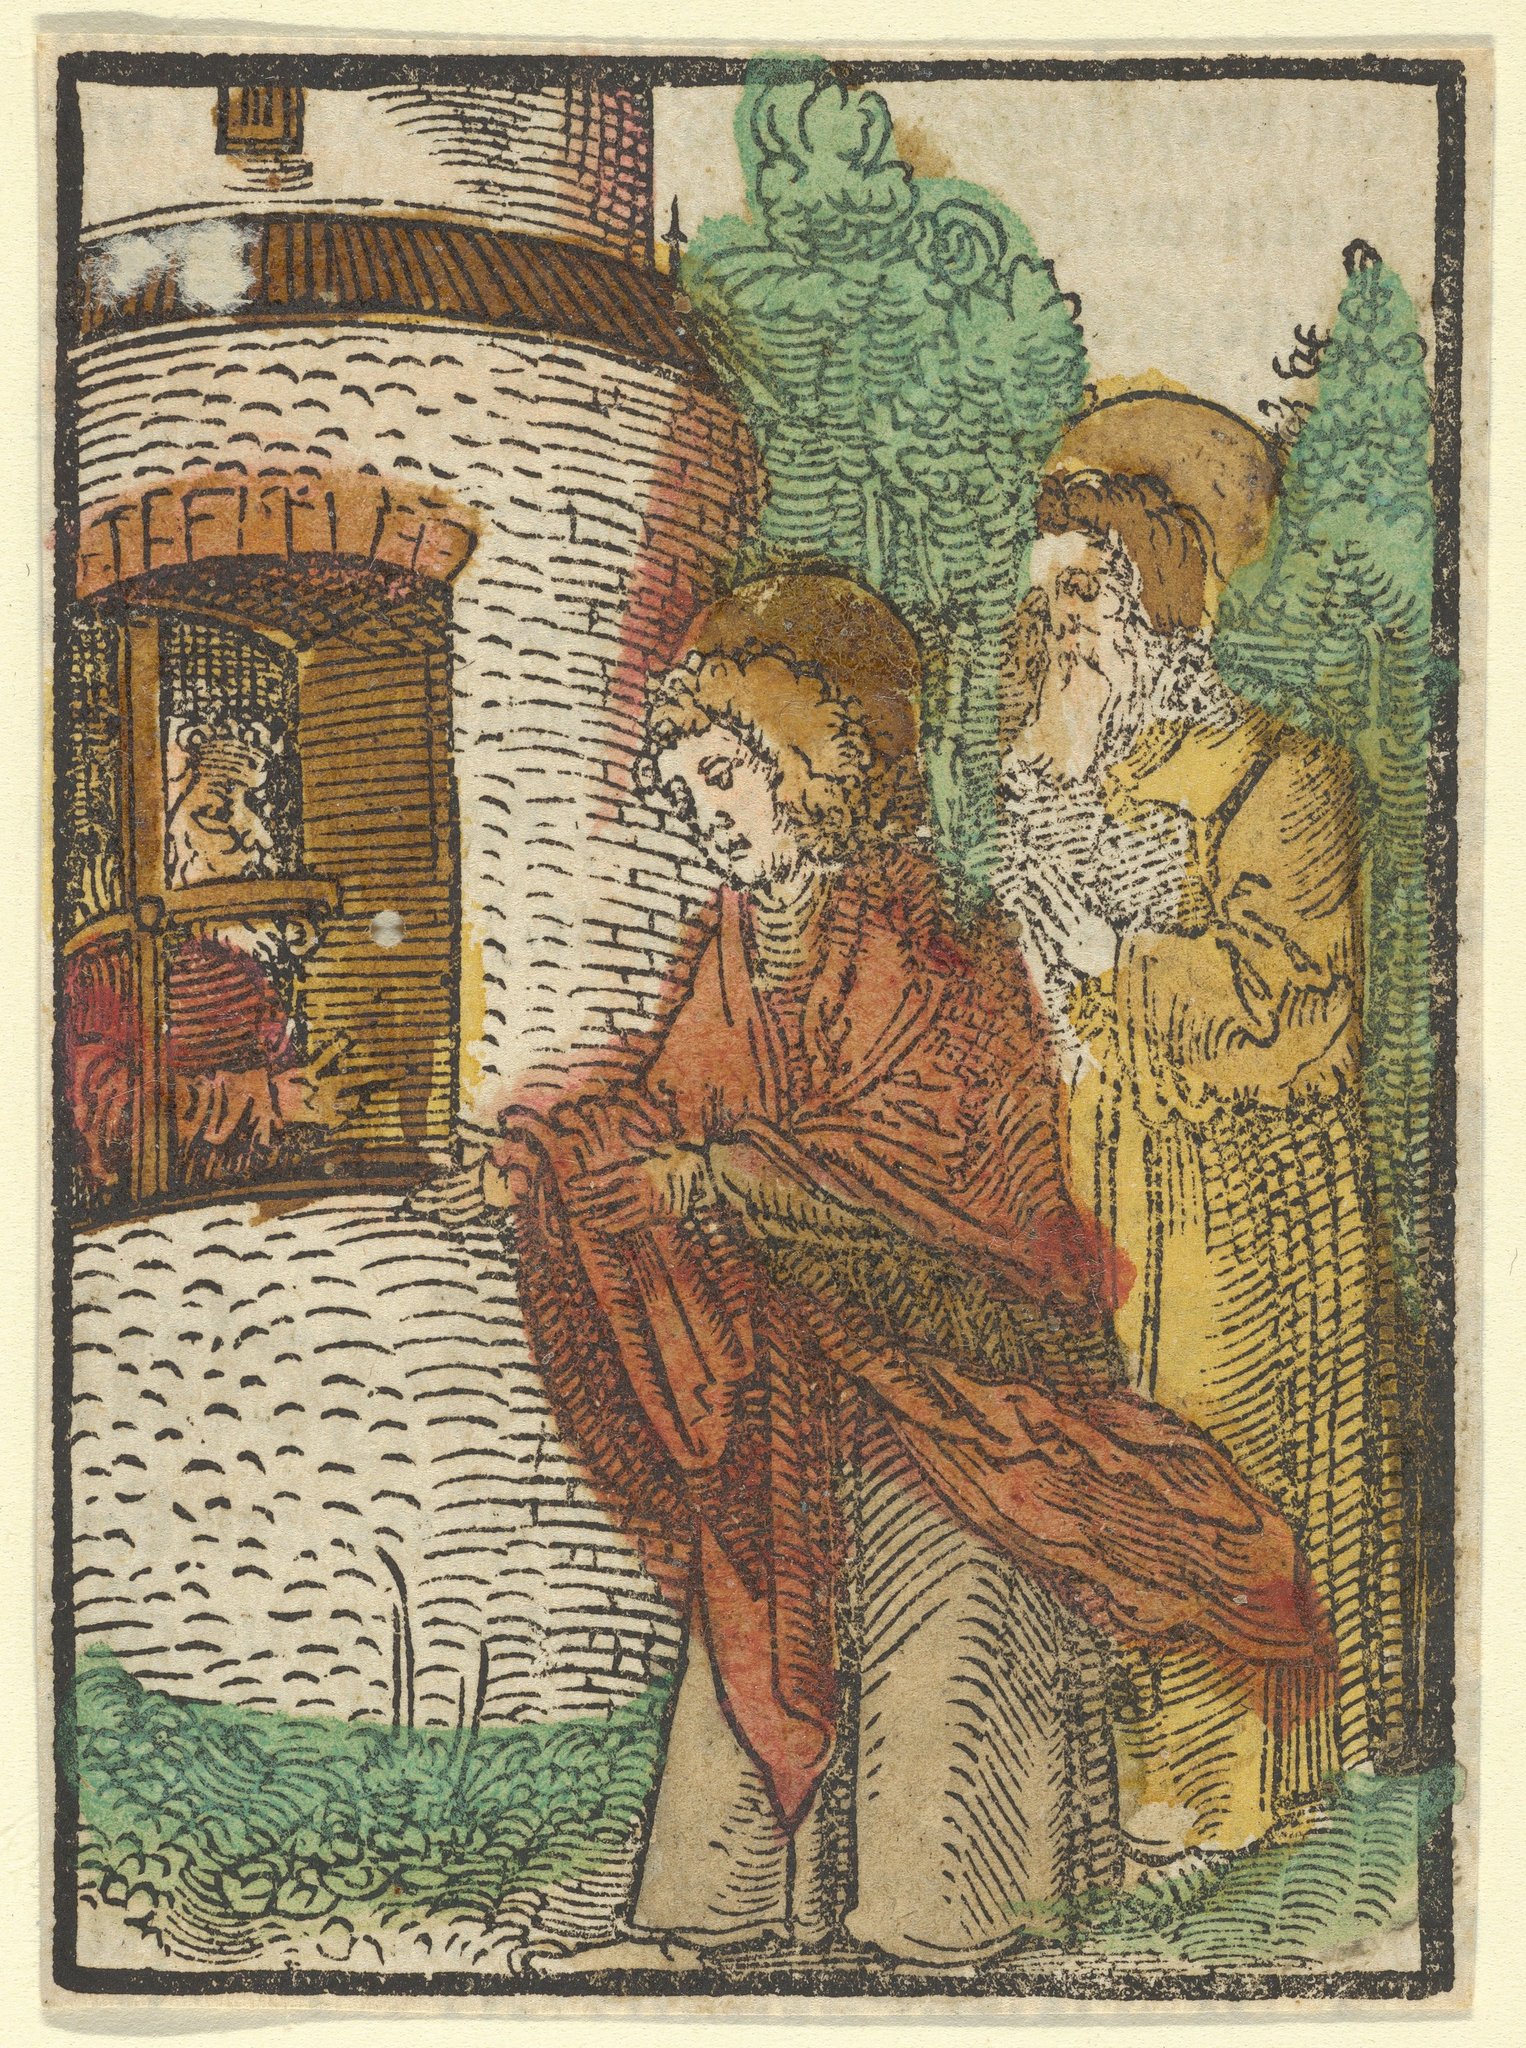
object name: print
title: St. John in Prison, from Das Plenarium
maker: hans schäufelein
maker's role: artist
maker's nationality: german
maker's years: 1480-1540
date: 1517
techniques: hand coloring, woodcut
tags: prisons,saint john the baptist,saints